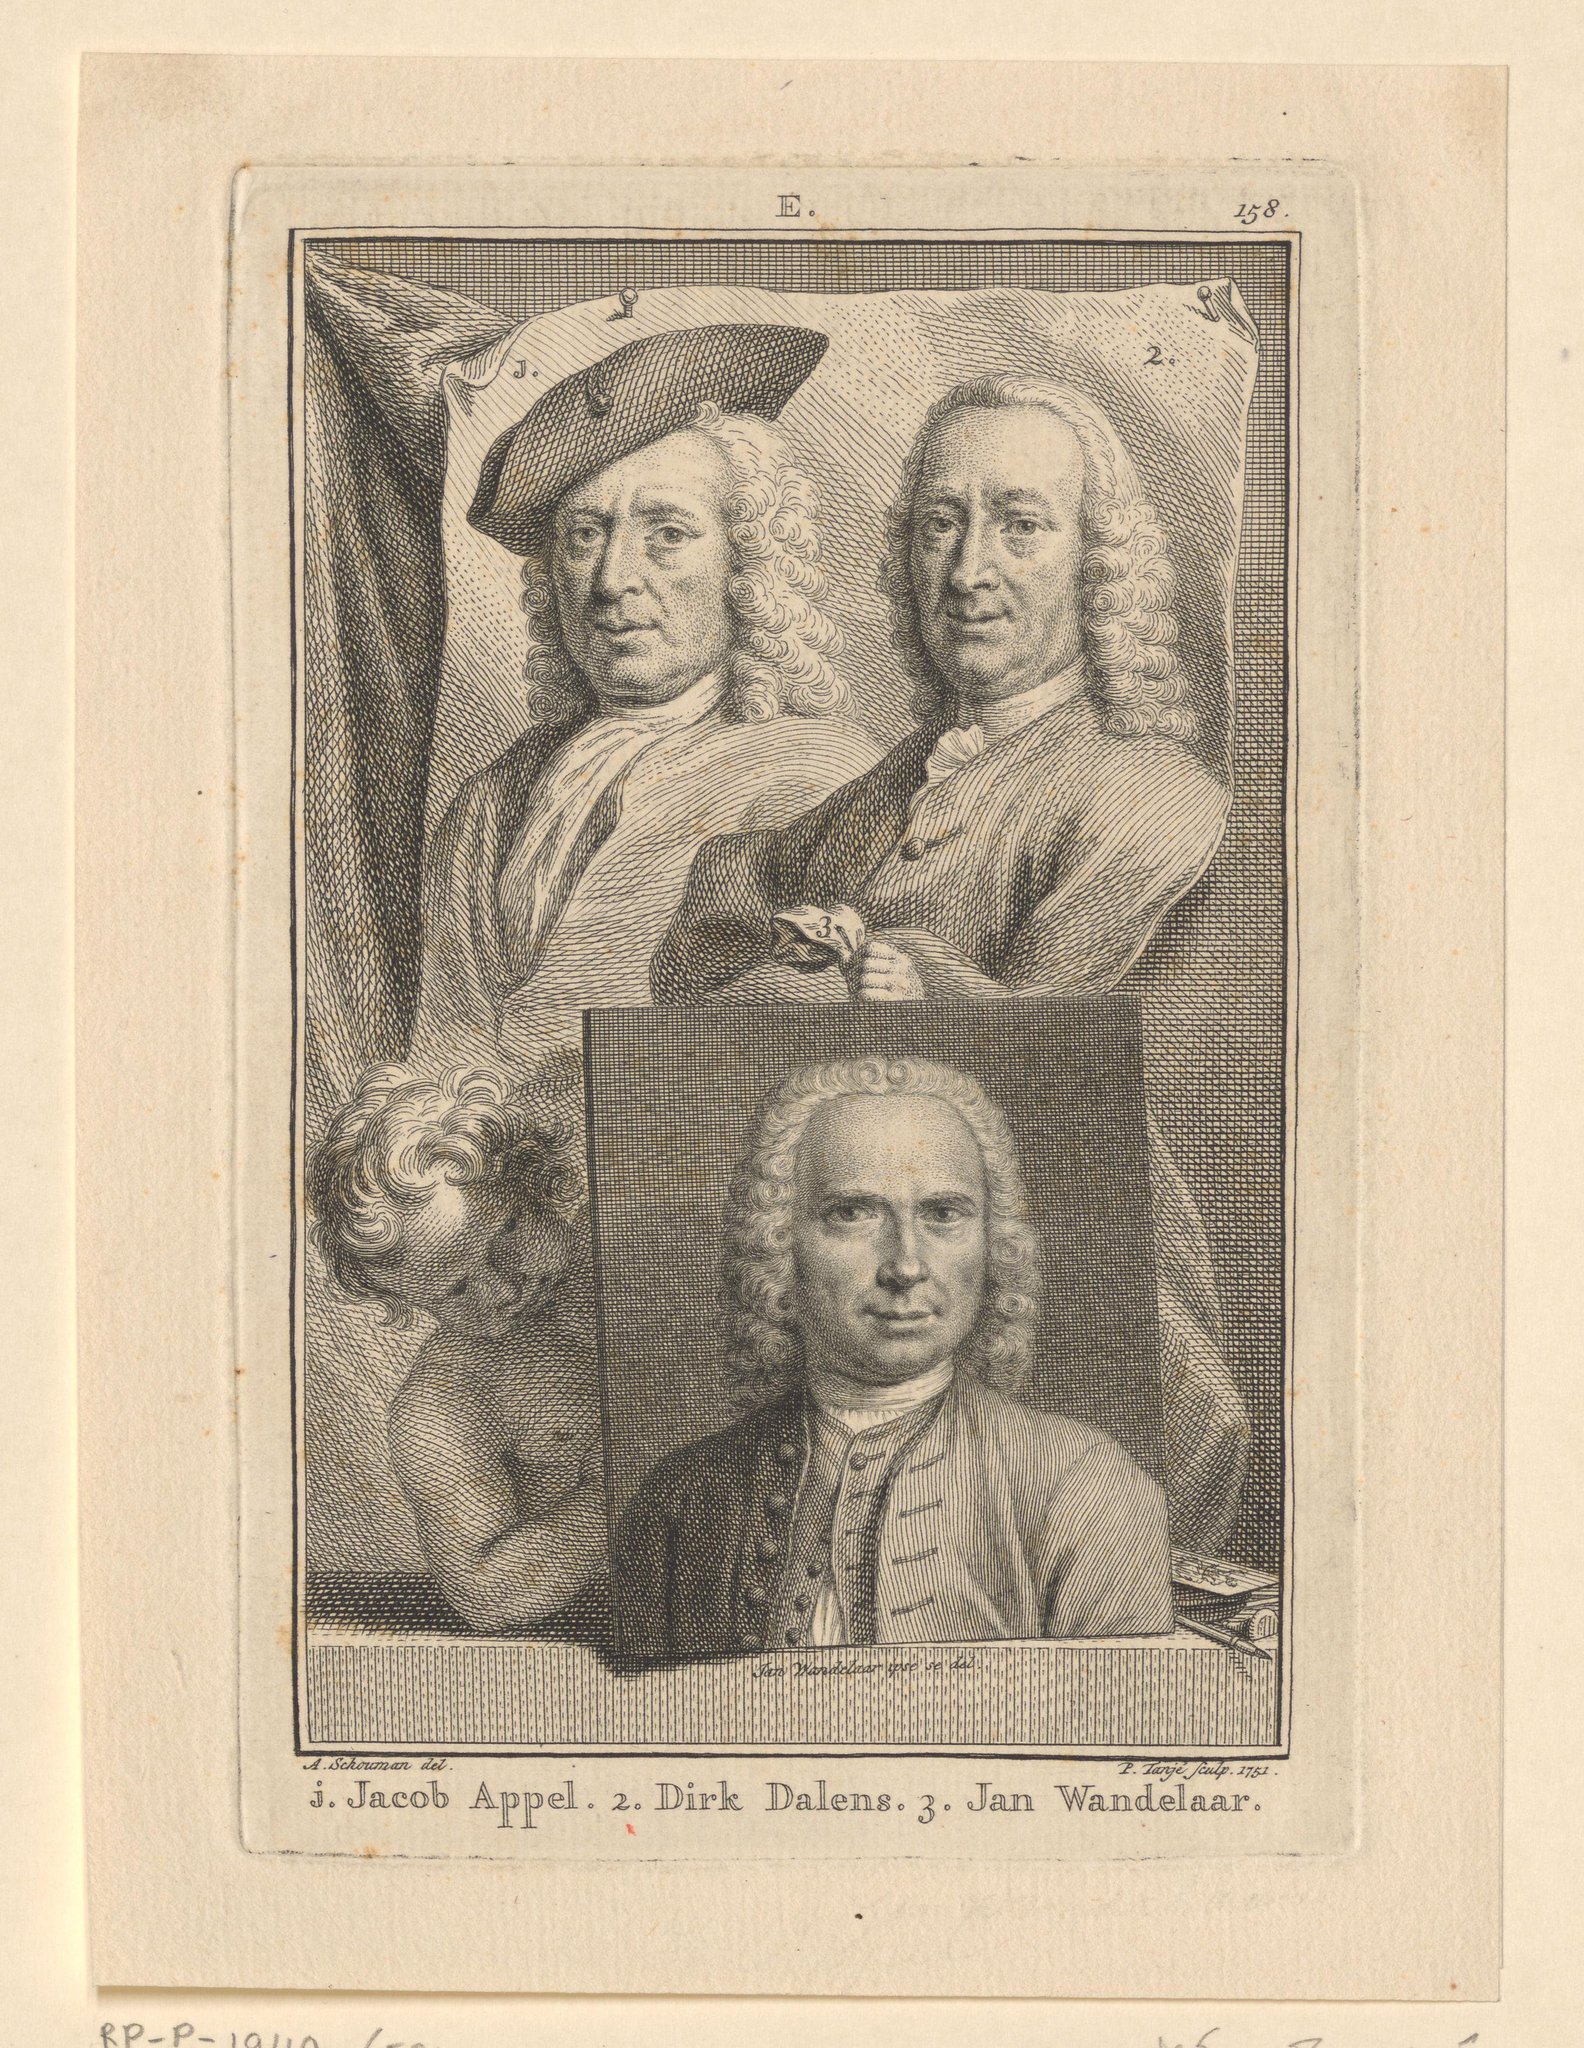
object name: book illustration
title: Portretten van Jacob Appel, Dirk Dalens en Jan Wandelaar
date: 1751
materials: paper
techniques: engraving, etching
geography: the hague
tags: amsterdam, draughtsman, jacob appel (i), painter, leiden, print maker, jan wandelaar, historical persons, portrait, self-portrait of painter, cupids: 'amores', 'amoretti', 'putti'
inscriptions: inscription: ‘JVGool’, collector's mark: Lugt 2760, collector's mark: Lugt 2228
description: Prent uit: Gool, Jan van. De nieuwe schouburg der Nederlantsche kunstschilders en schilderessen (...). Den Haag: Jan van Gool, 1751, dl. 2.